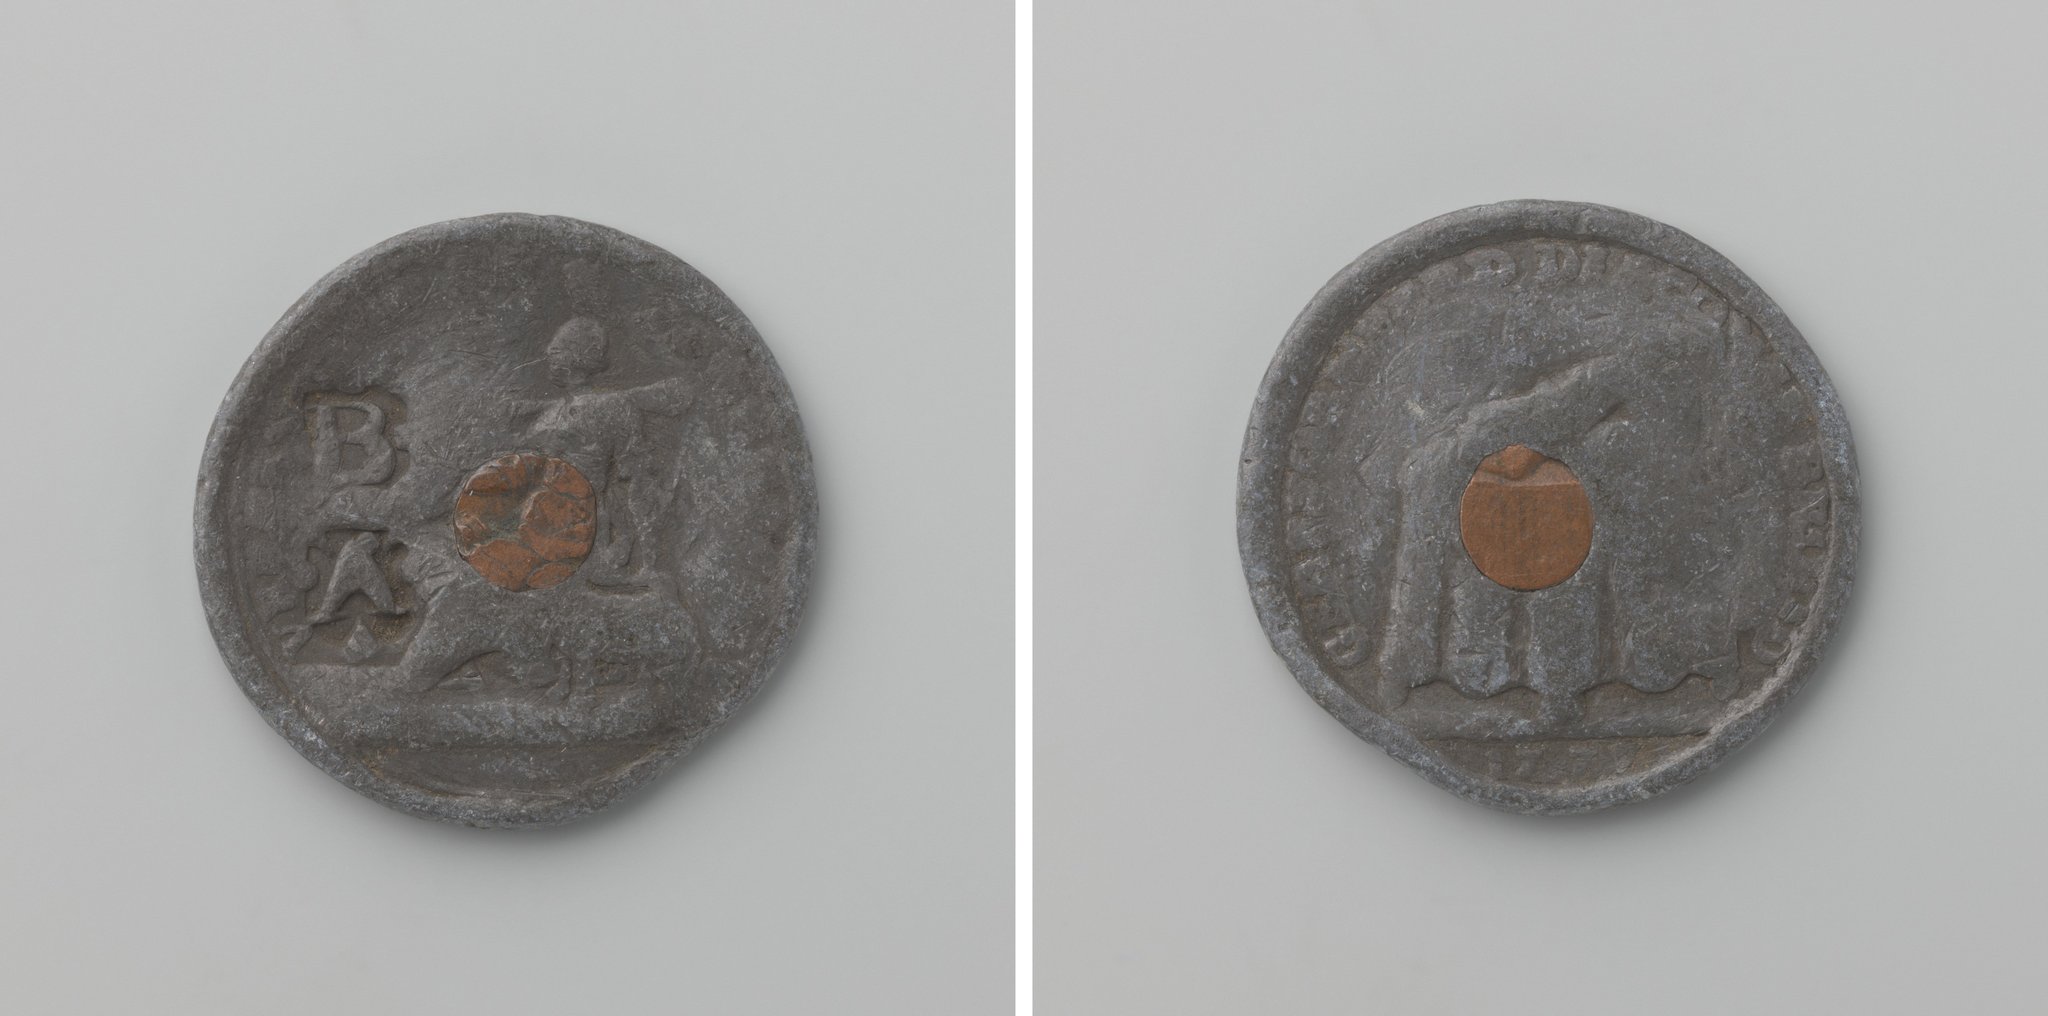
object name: alms token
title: Broodpenning van de Gereformeerde Diaconie te Amsterdam 1777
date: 1777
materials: copper, tin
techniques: striking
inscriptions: circumscription: ‘GEREFORMEERD DIACONIE BROOD’, circumscription: ‘VERGENOEGD EN DANKBAAR’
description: Tinnen penning met brede koperen plug, op de voorzijde een vrouw zittend naast een schaap, een duif op haar hoofd en een juk om haar nek, met omschrift, op de keerzijde twee broden op een beklede tafel, met omschrift, in afsnede 1777